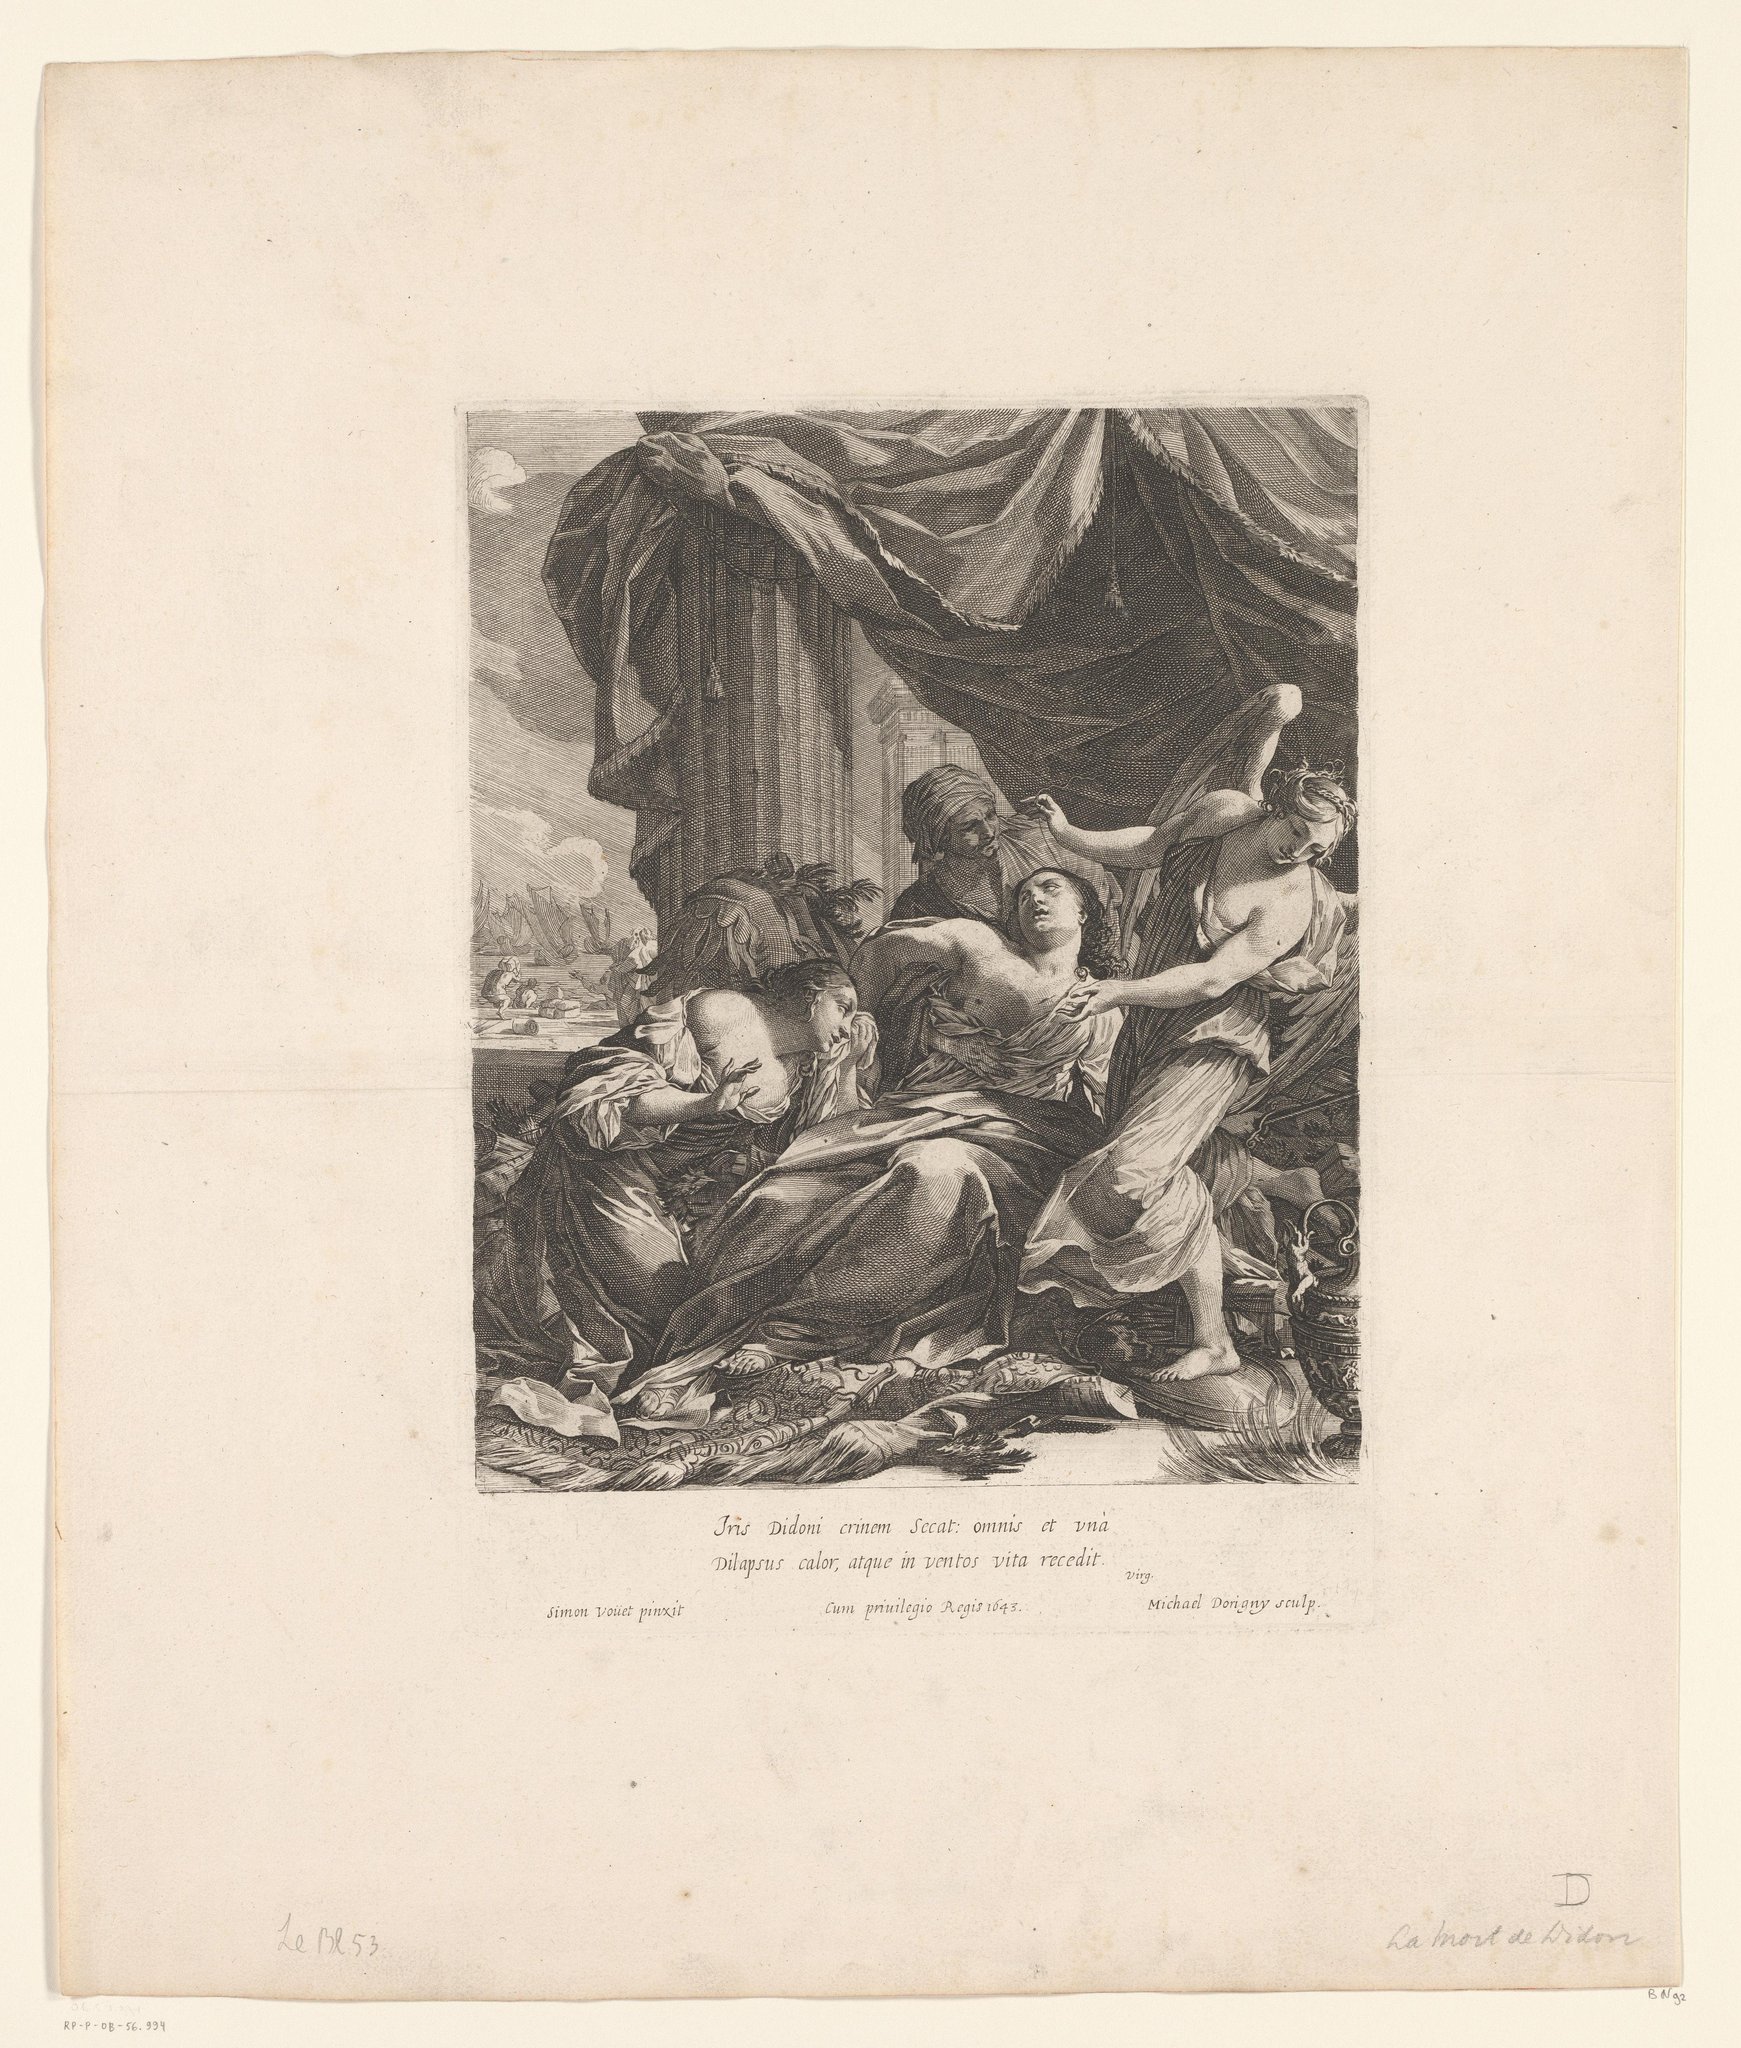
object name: print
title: Dood van Dido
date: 1643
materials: paper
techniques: engraving, etching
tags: (story of) dido - death, iris cuts a lock from dido's hair to release her soul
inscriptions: collector's mark: Lugt 2228